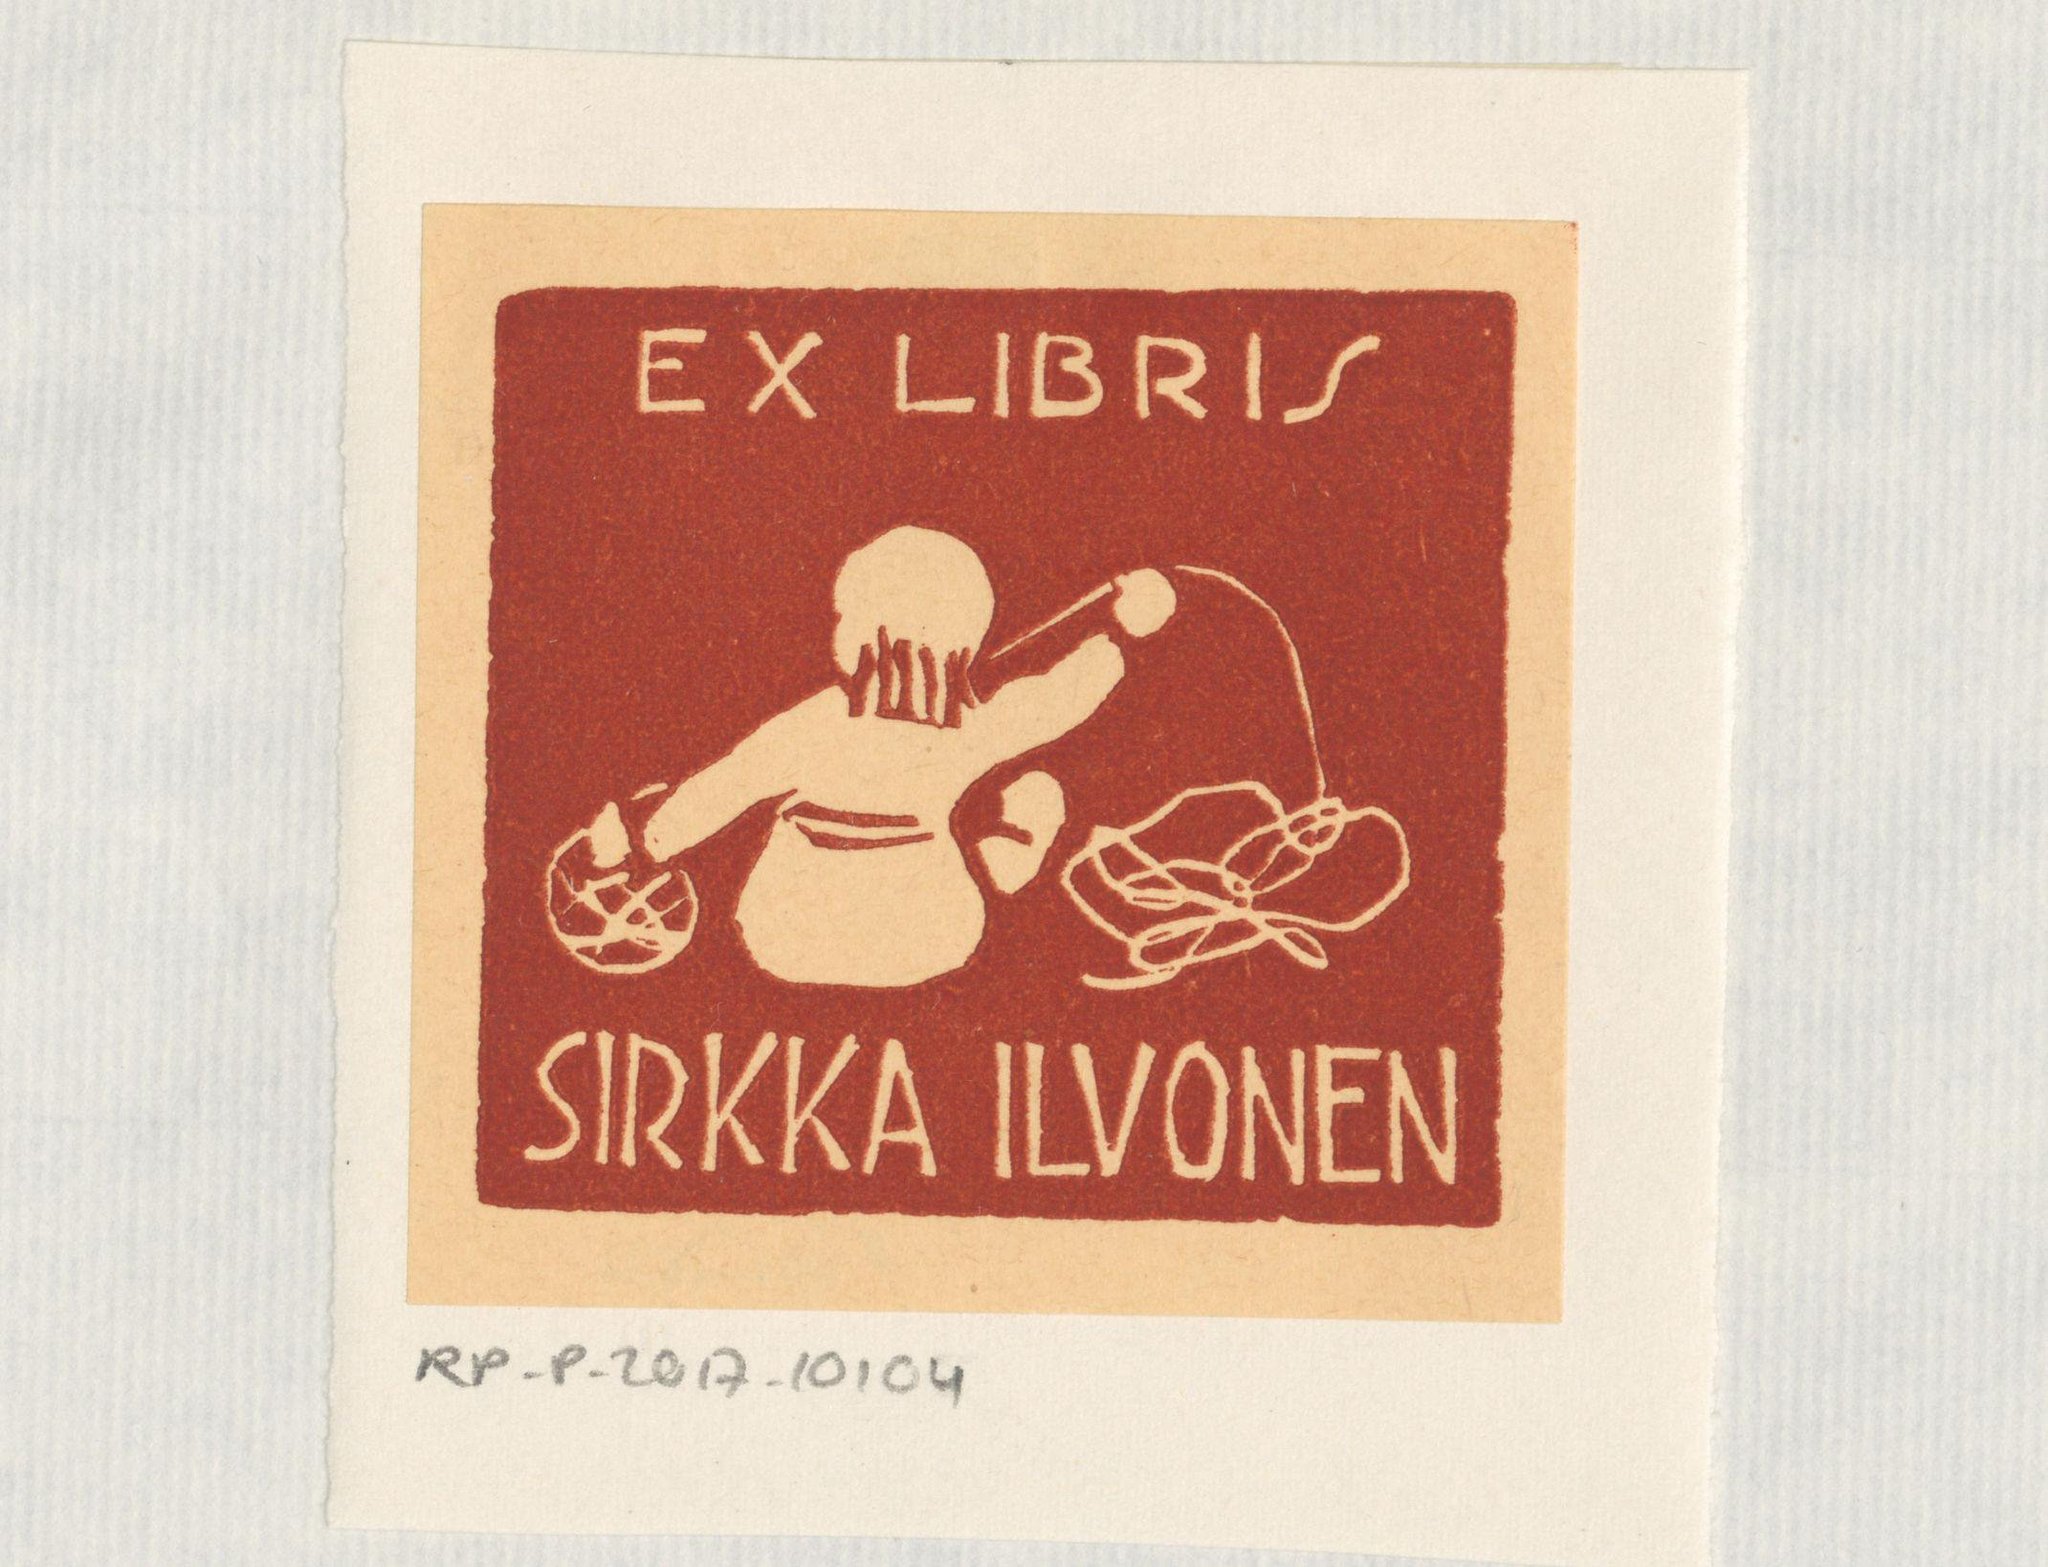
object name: bookplate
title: Ex libris van Sirkka Ilvonen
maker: pekka törmä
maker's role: print maker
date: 1945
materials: paper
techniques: linocut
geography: denmark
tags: toddler (female)